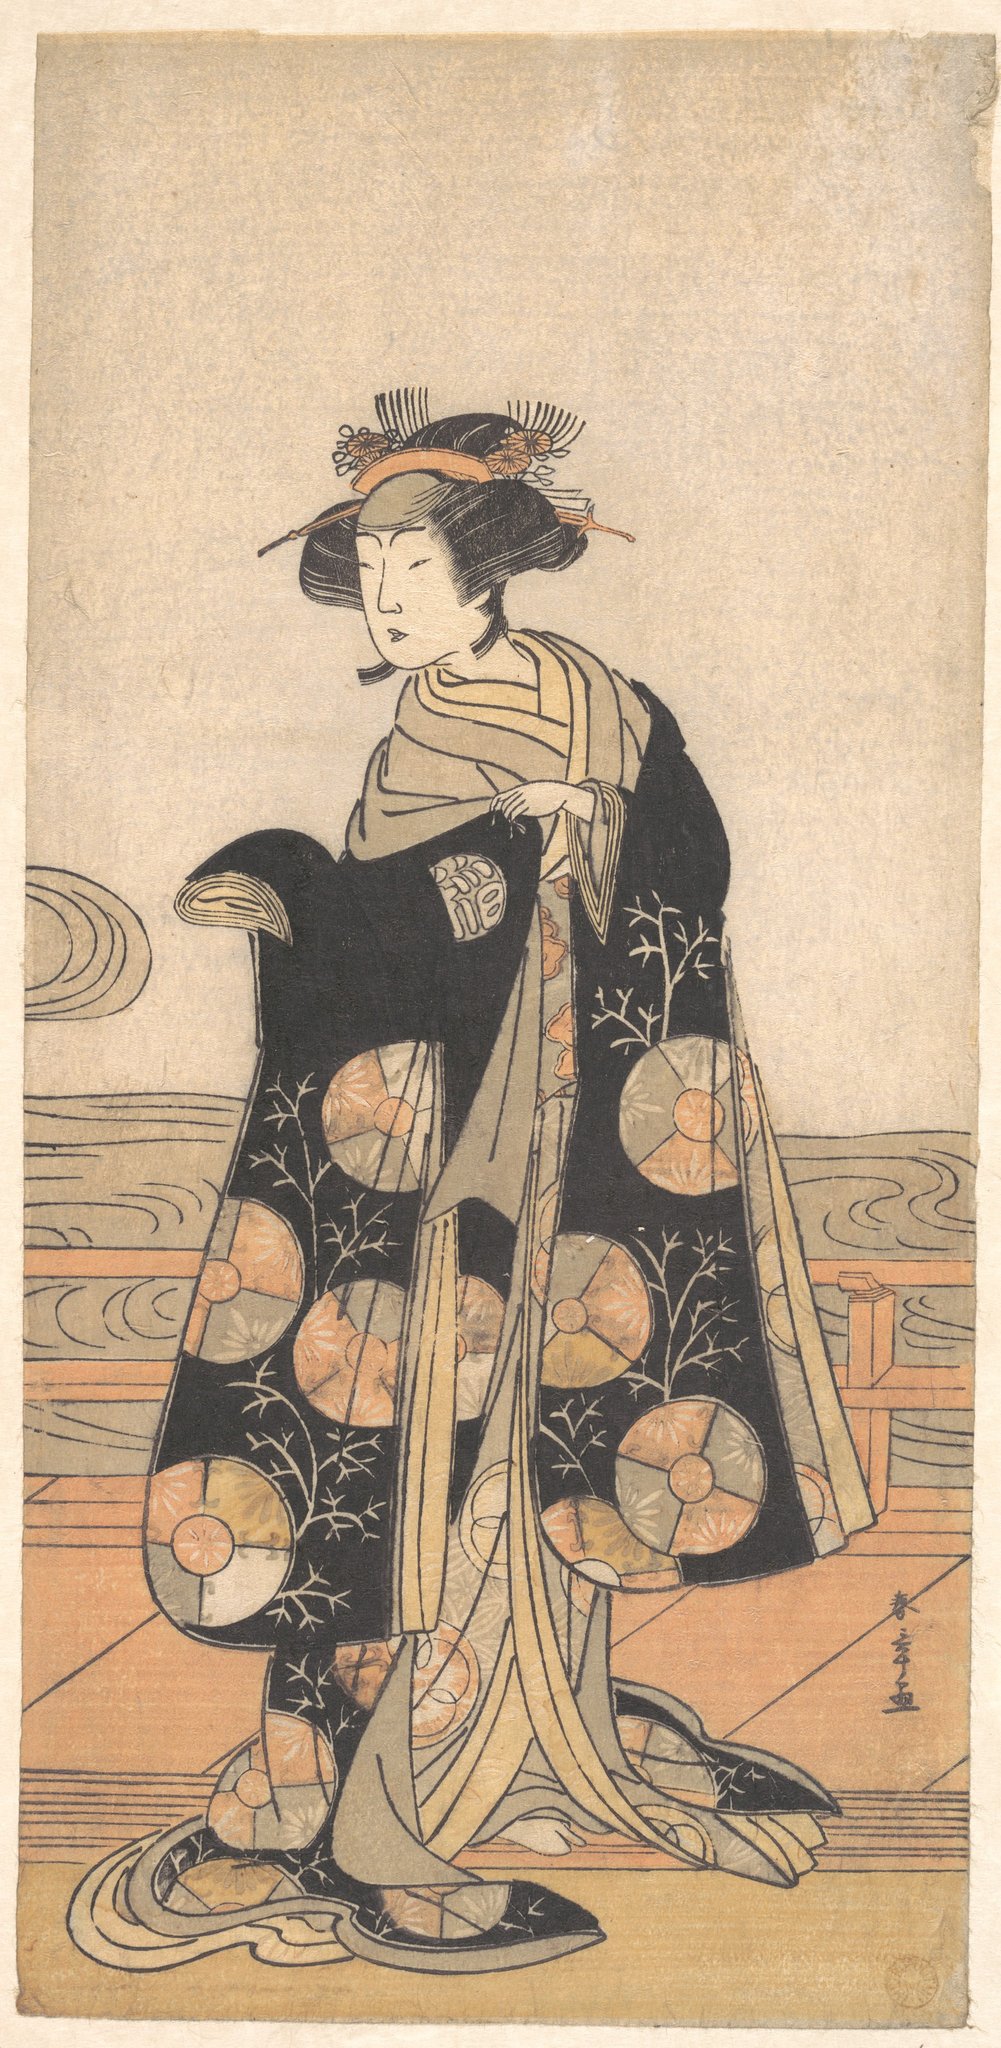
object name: woodblock print nishiki e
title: Yoshizawa Iroha as a Woman Standing on the Engawa of a House by a River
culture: japanese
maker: katsukawa shunshō 勝川春章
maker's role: artist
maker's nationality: japanese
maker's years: 1726-1792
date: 1778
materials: ink, paper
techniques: nishiki e, woodblock print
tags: men,women,actors